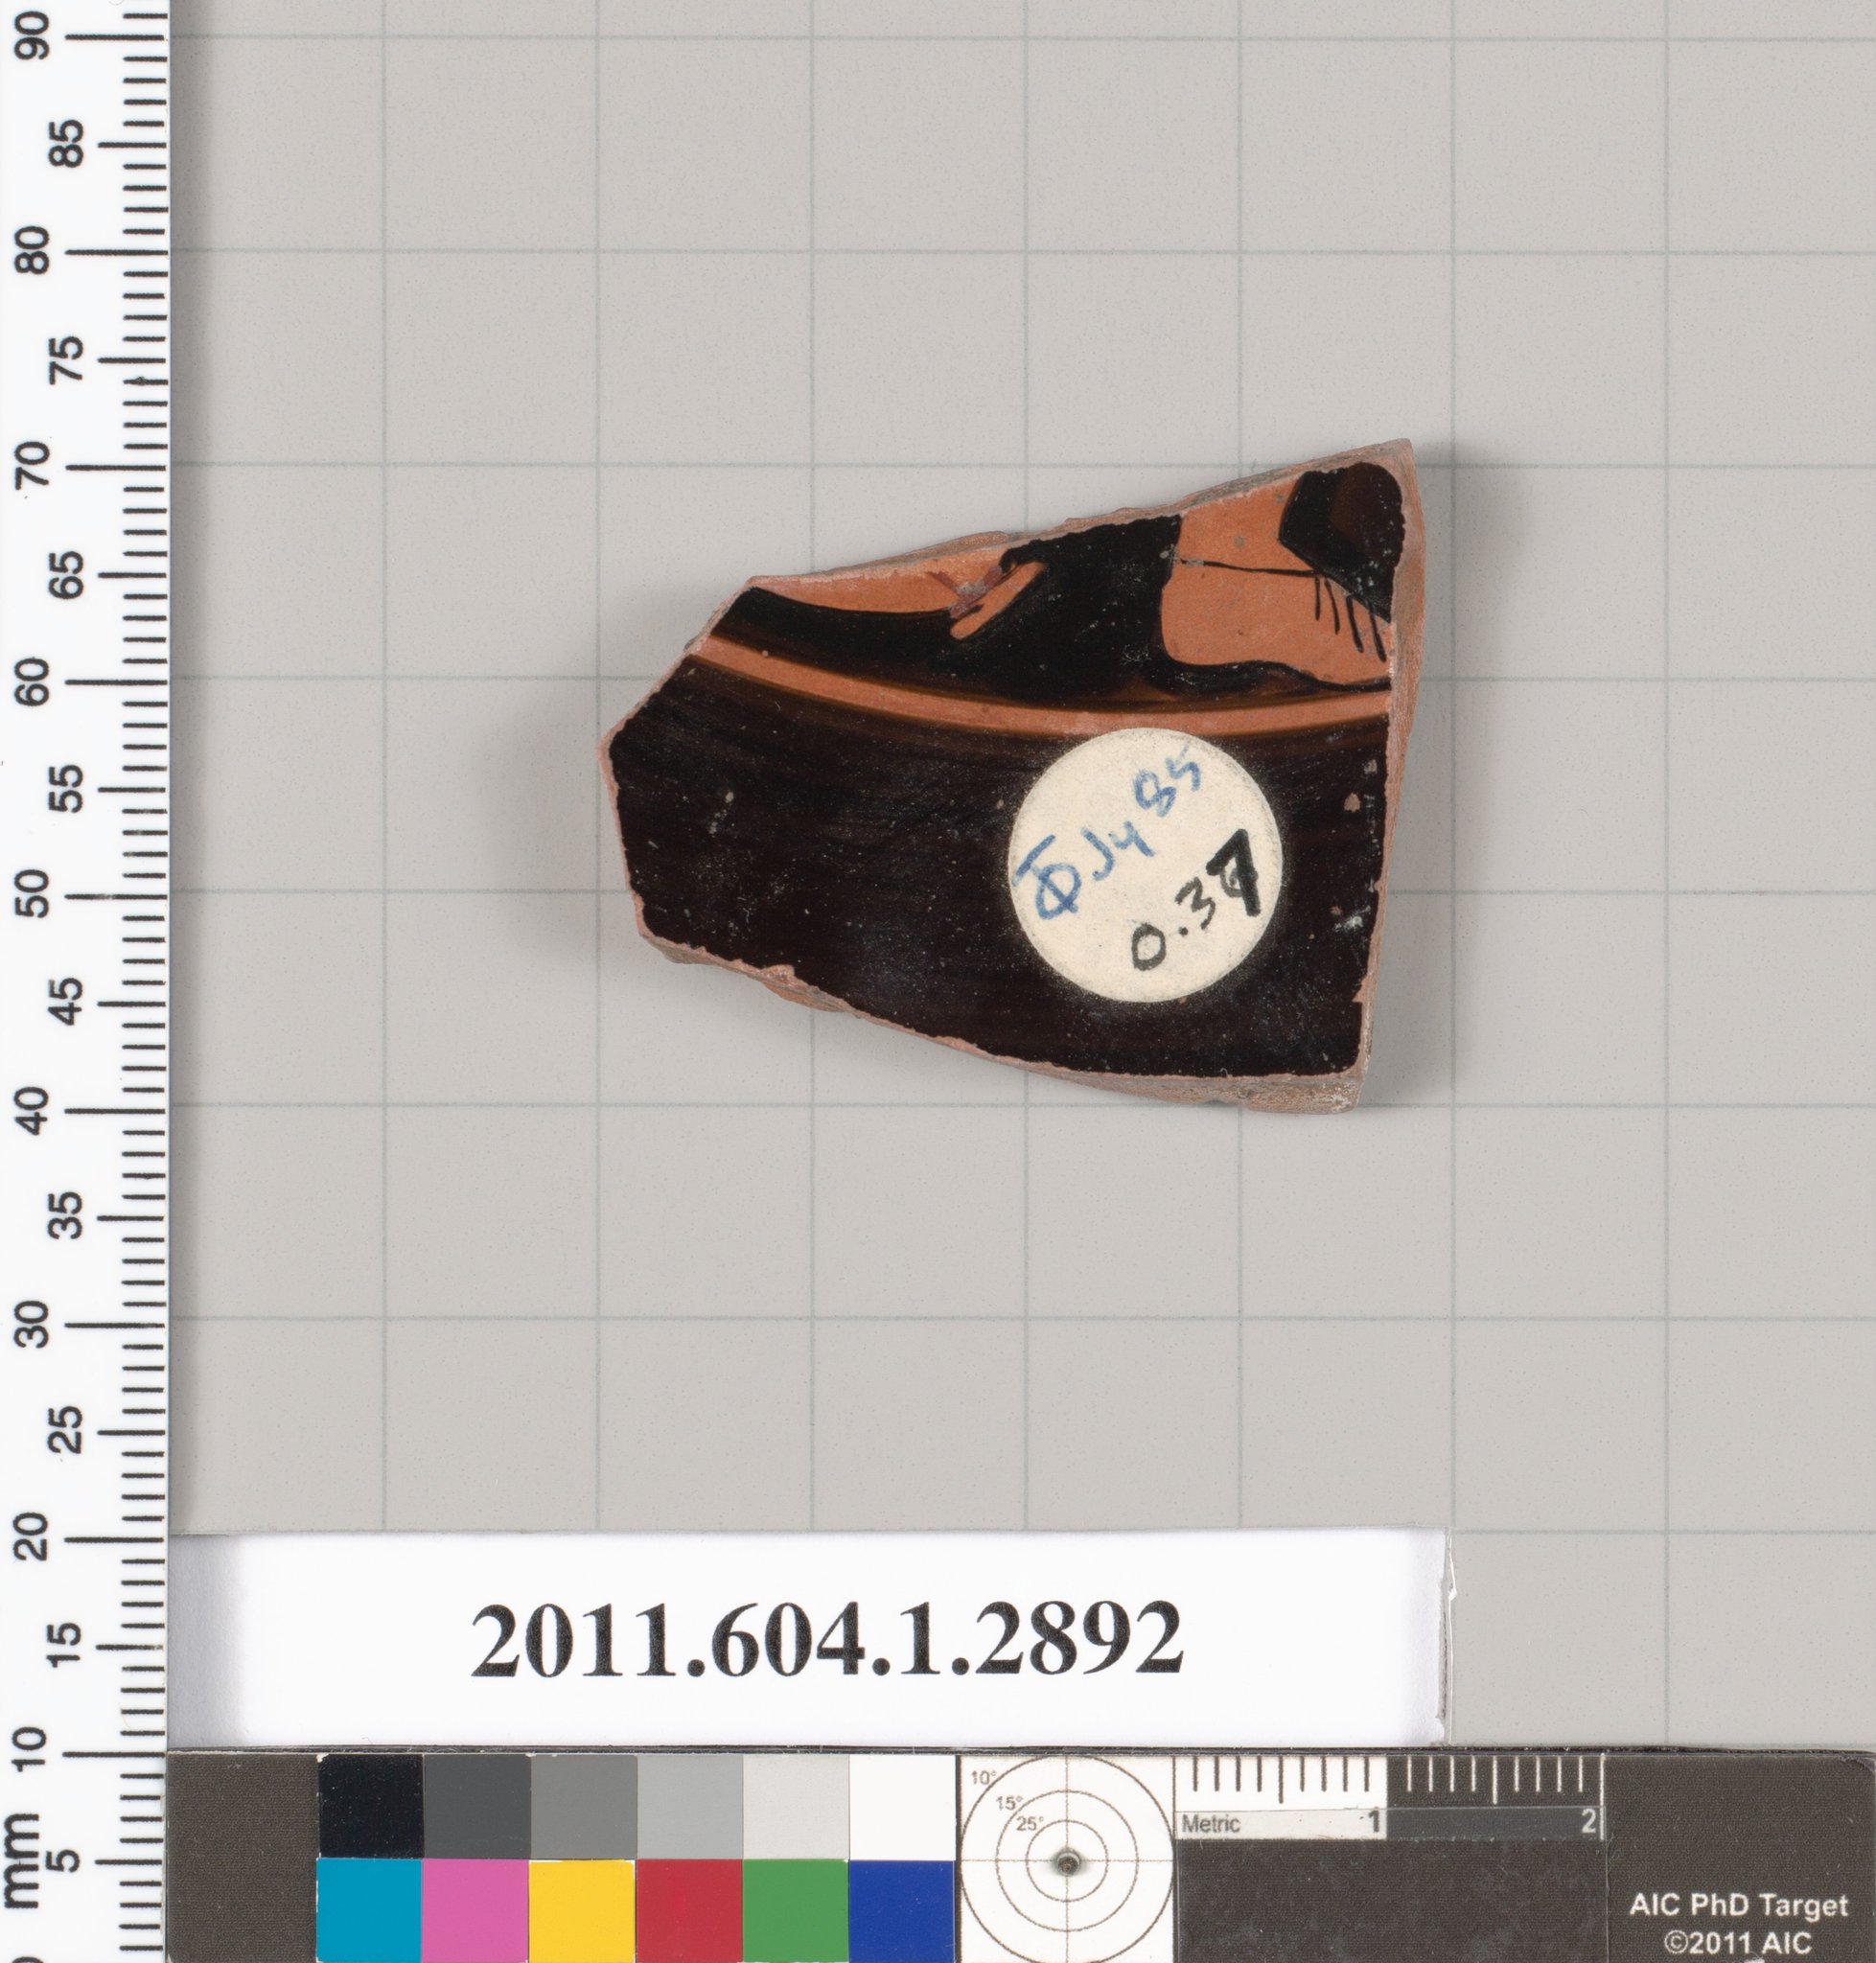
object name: kylix fragment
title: Terracotta fragment of a kylix (drinking cup)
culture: greek, attic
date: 500-490 BCE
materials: terracotta